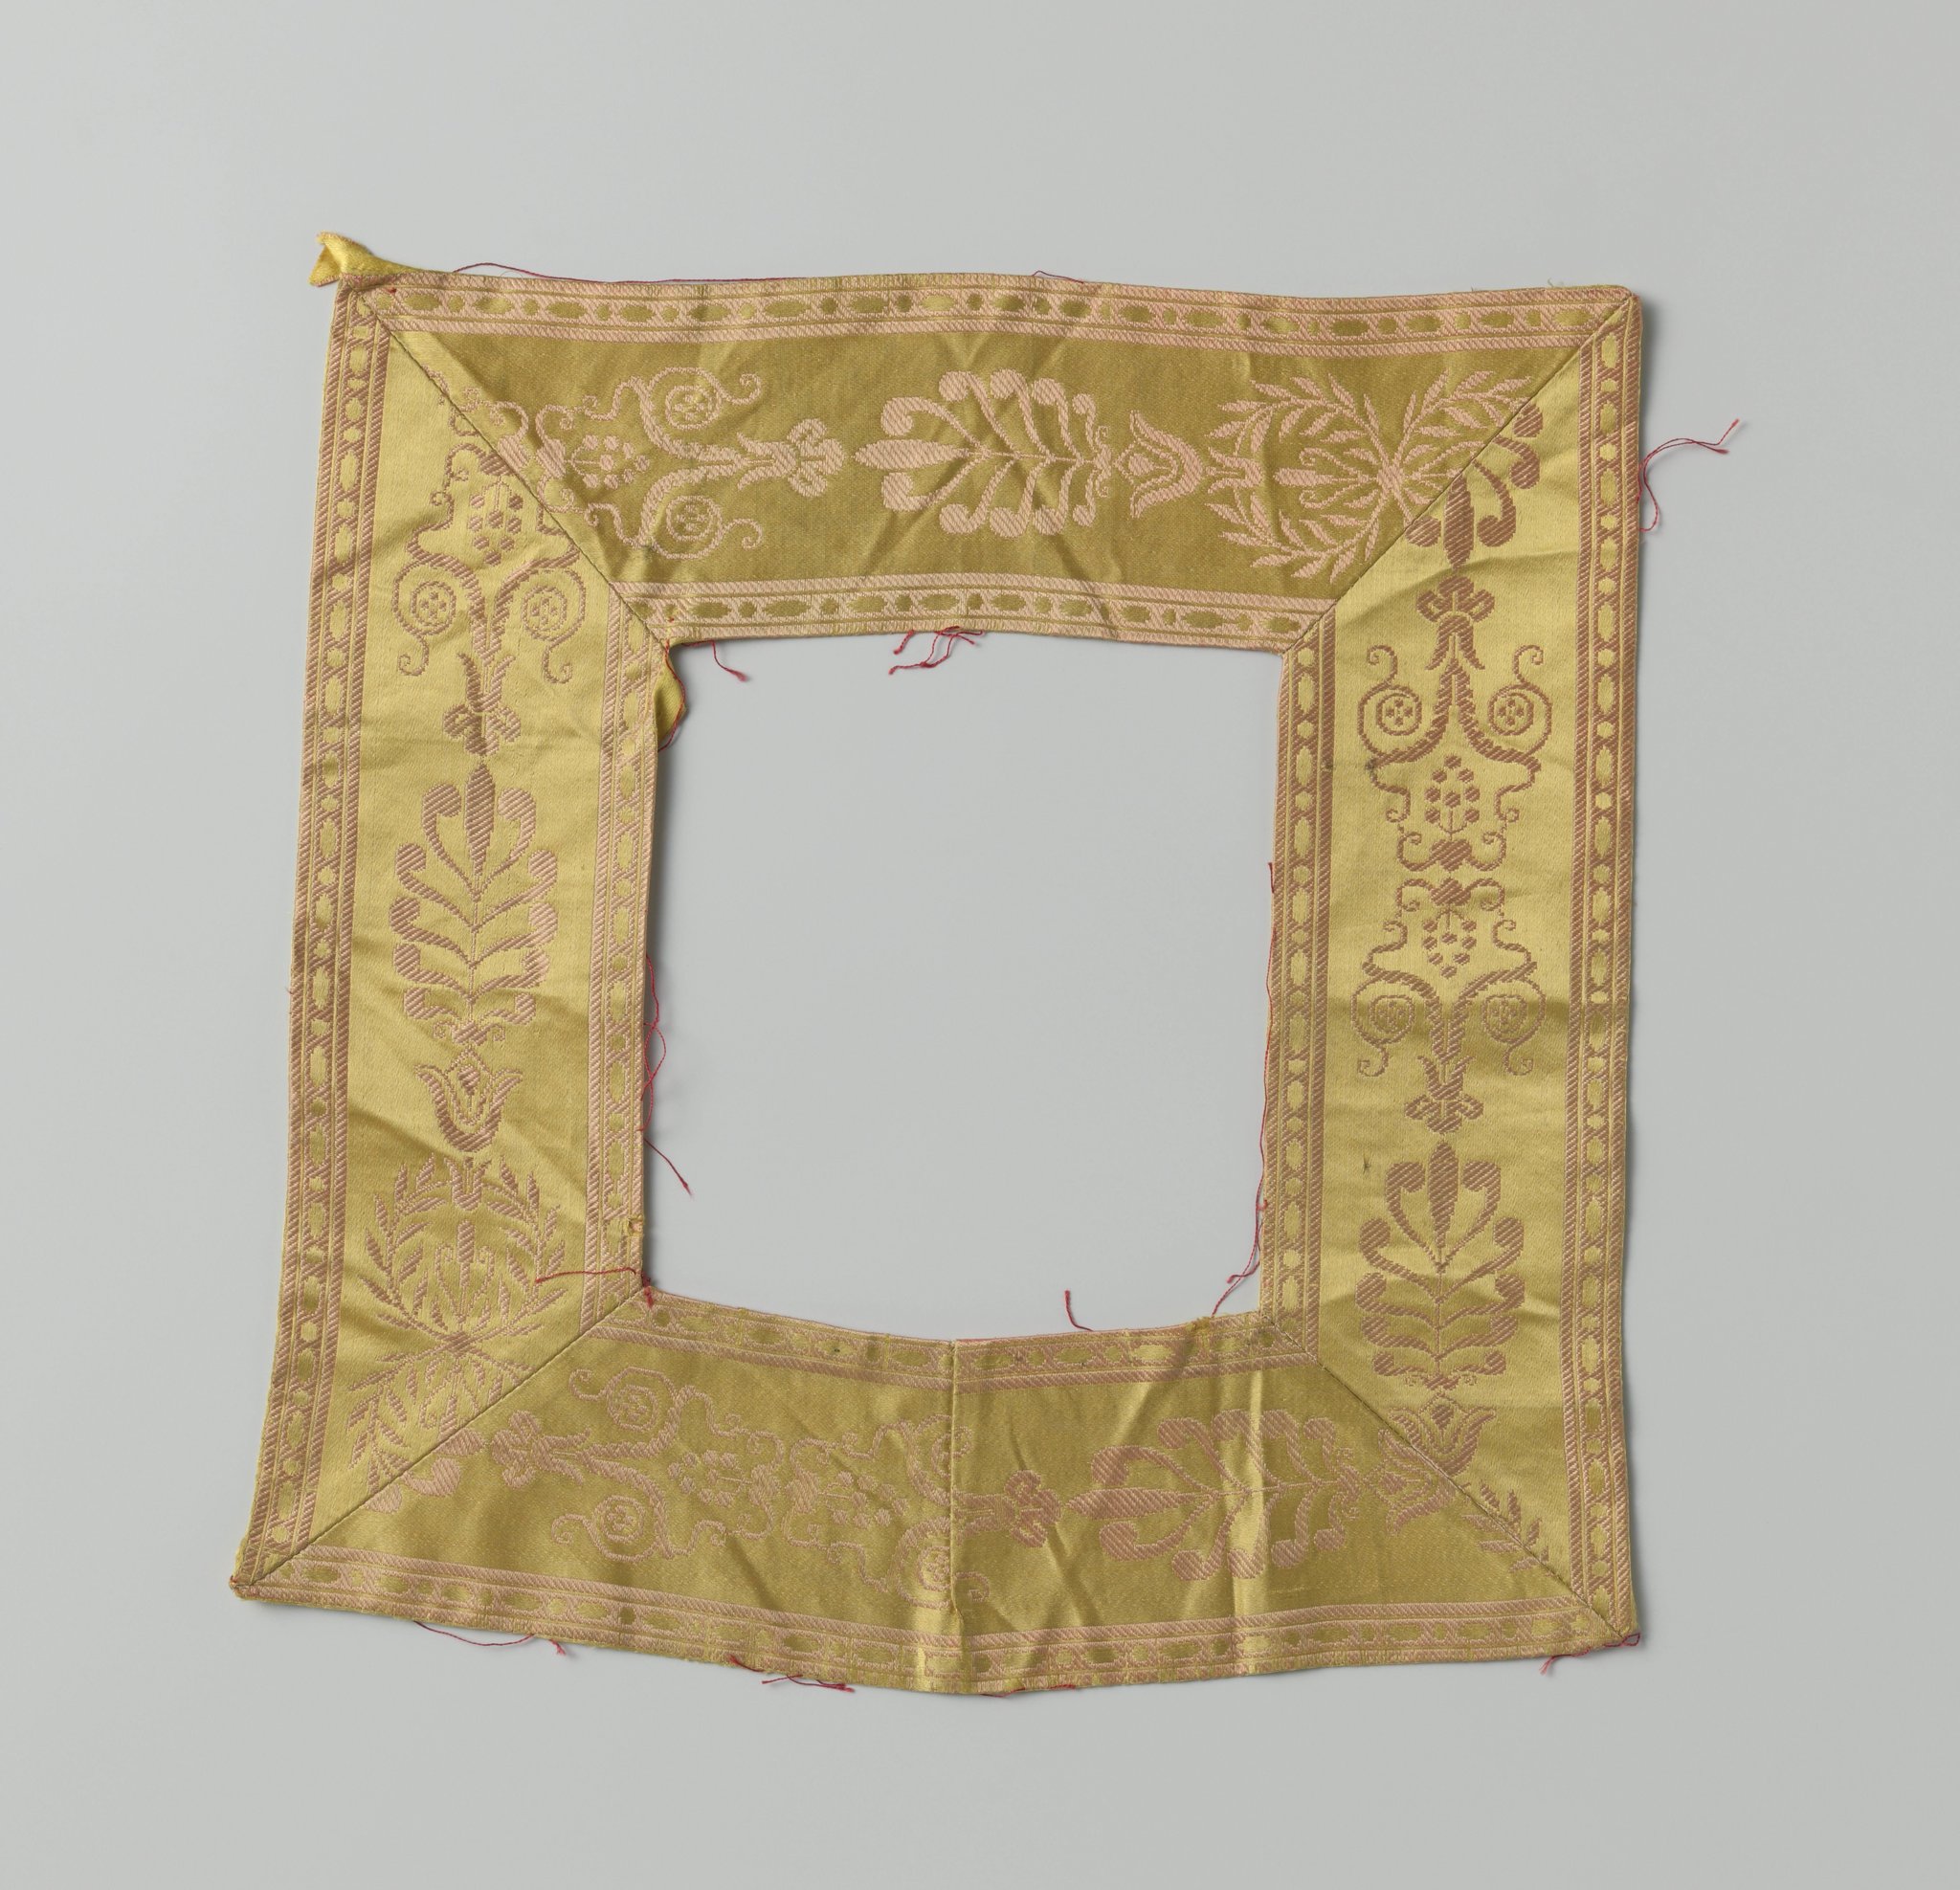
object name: stoelbekleding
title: Fragment zijdeweefsel van een stoelbekleding.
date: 1805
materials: silk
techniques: brocade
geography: france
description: Fragment geel zijdeweefsel, van een stoelbekleding. Het patroon heeft op een gele grond roze palmetten en arabesken. Het fragment hoort bij dertien fragmenten met invnr. BK-1992-18-A t/m BK-1992-18-M.